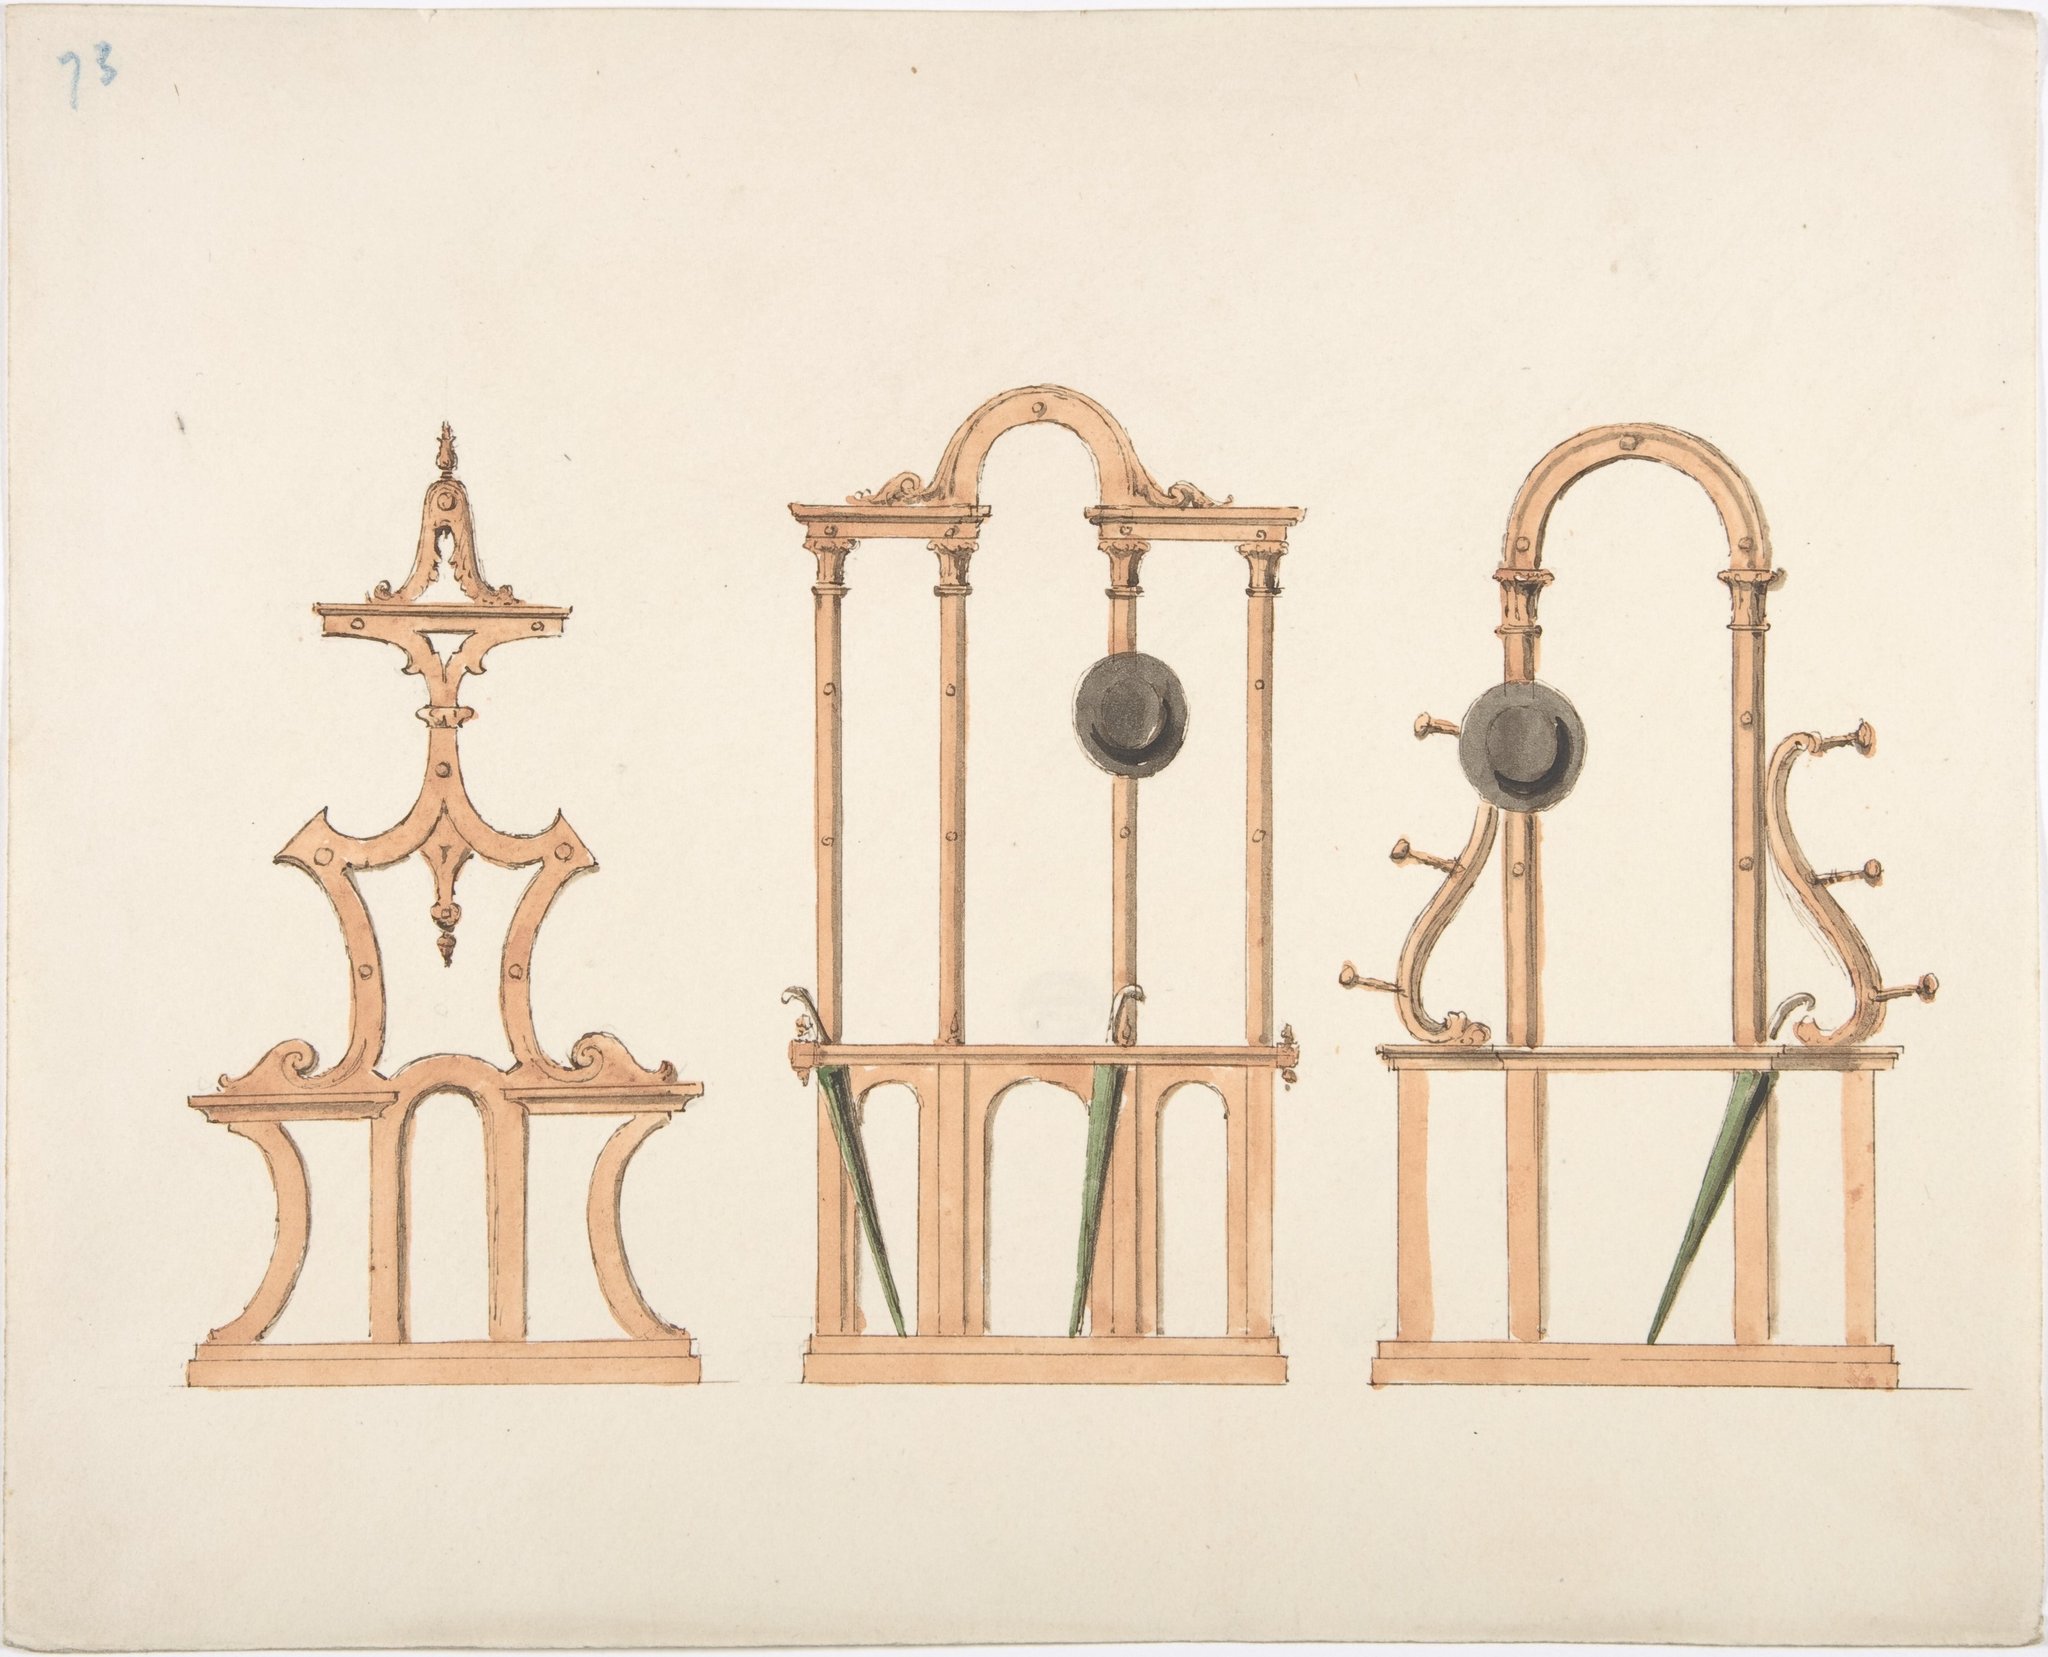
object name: drawing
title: Design for Three Hat and Umbrella Stands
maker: anonymous, british, 19th century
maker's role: artist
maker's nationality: british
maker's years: 1800-1900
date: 1830-1840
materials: ink, watercolor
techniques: pen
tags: furniture